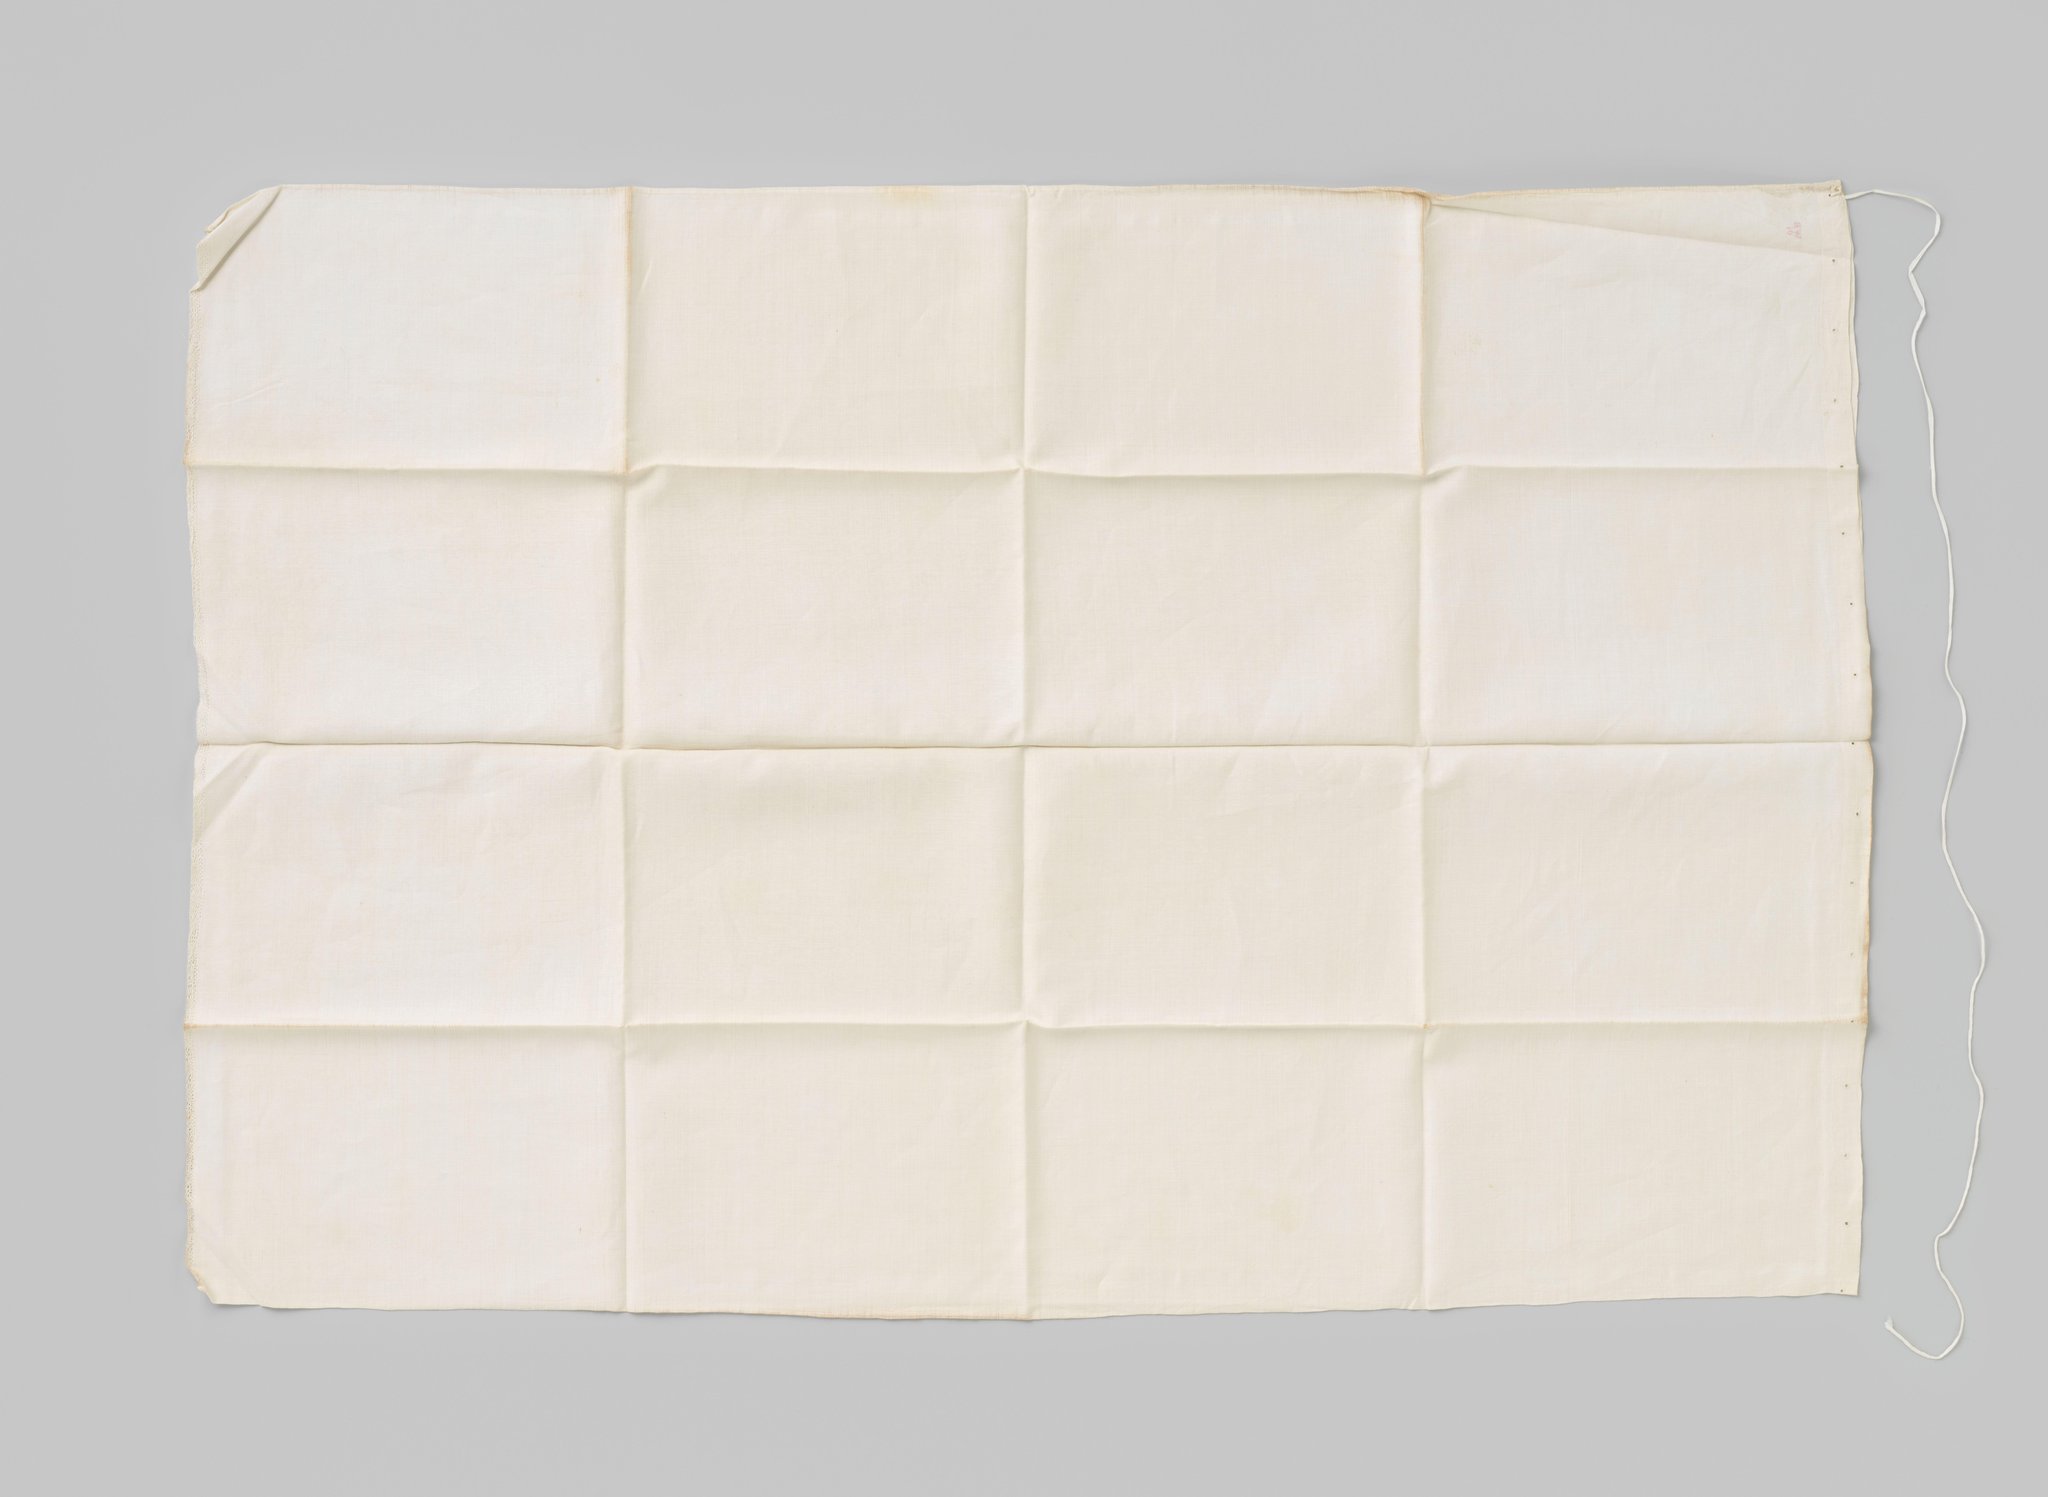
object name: sloop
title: Sloop van wit linnen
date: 1762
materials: linen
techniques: lace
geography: northern netherlands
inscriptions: : ‘HW10 (in rood)’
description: Wit linnen sloop met een kloskanten entredeux, merk kroon WG 24 1762 en HW 10 WH 2oonl.